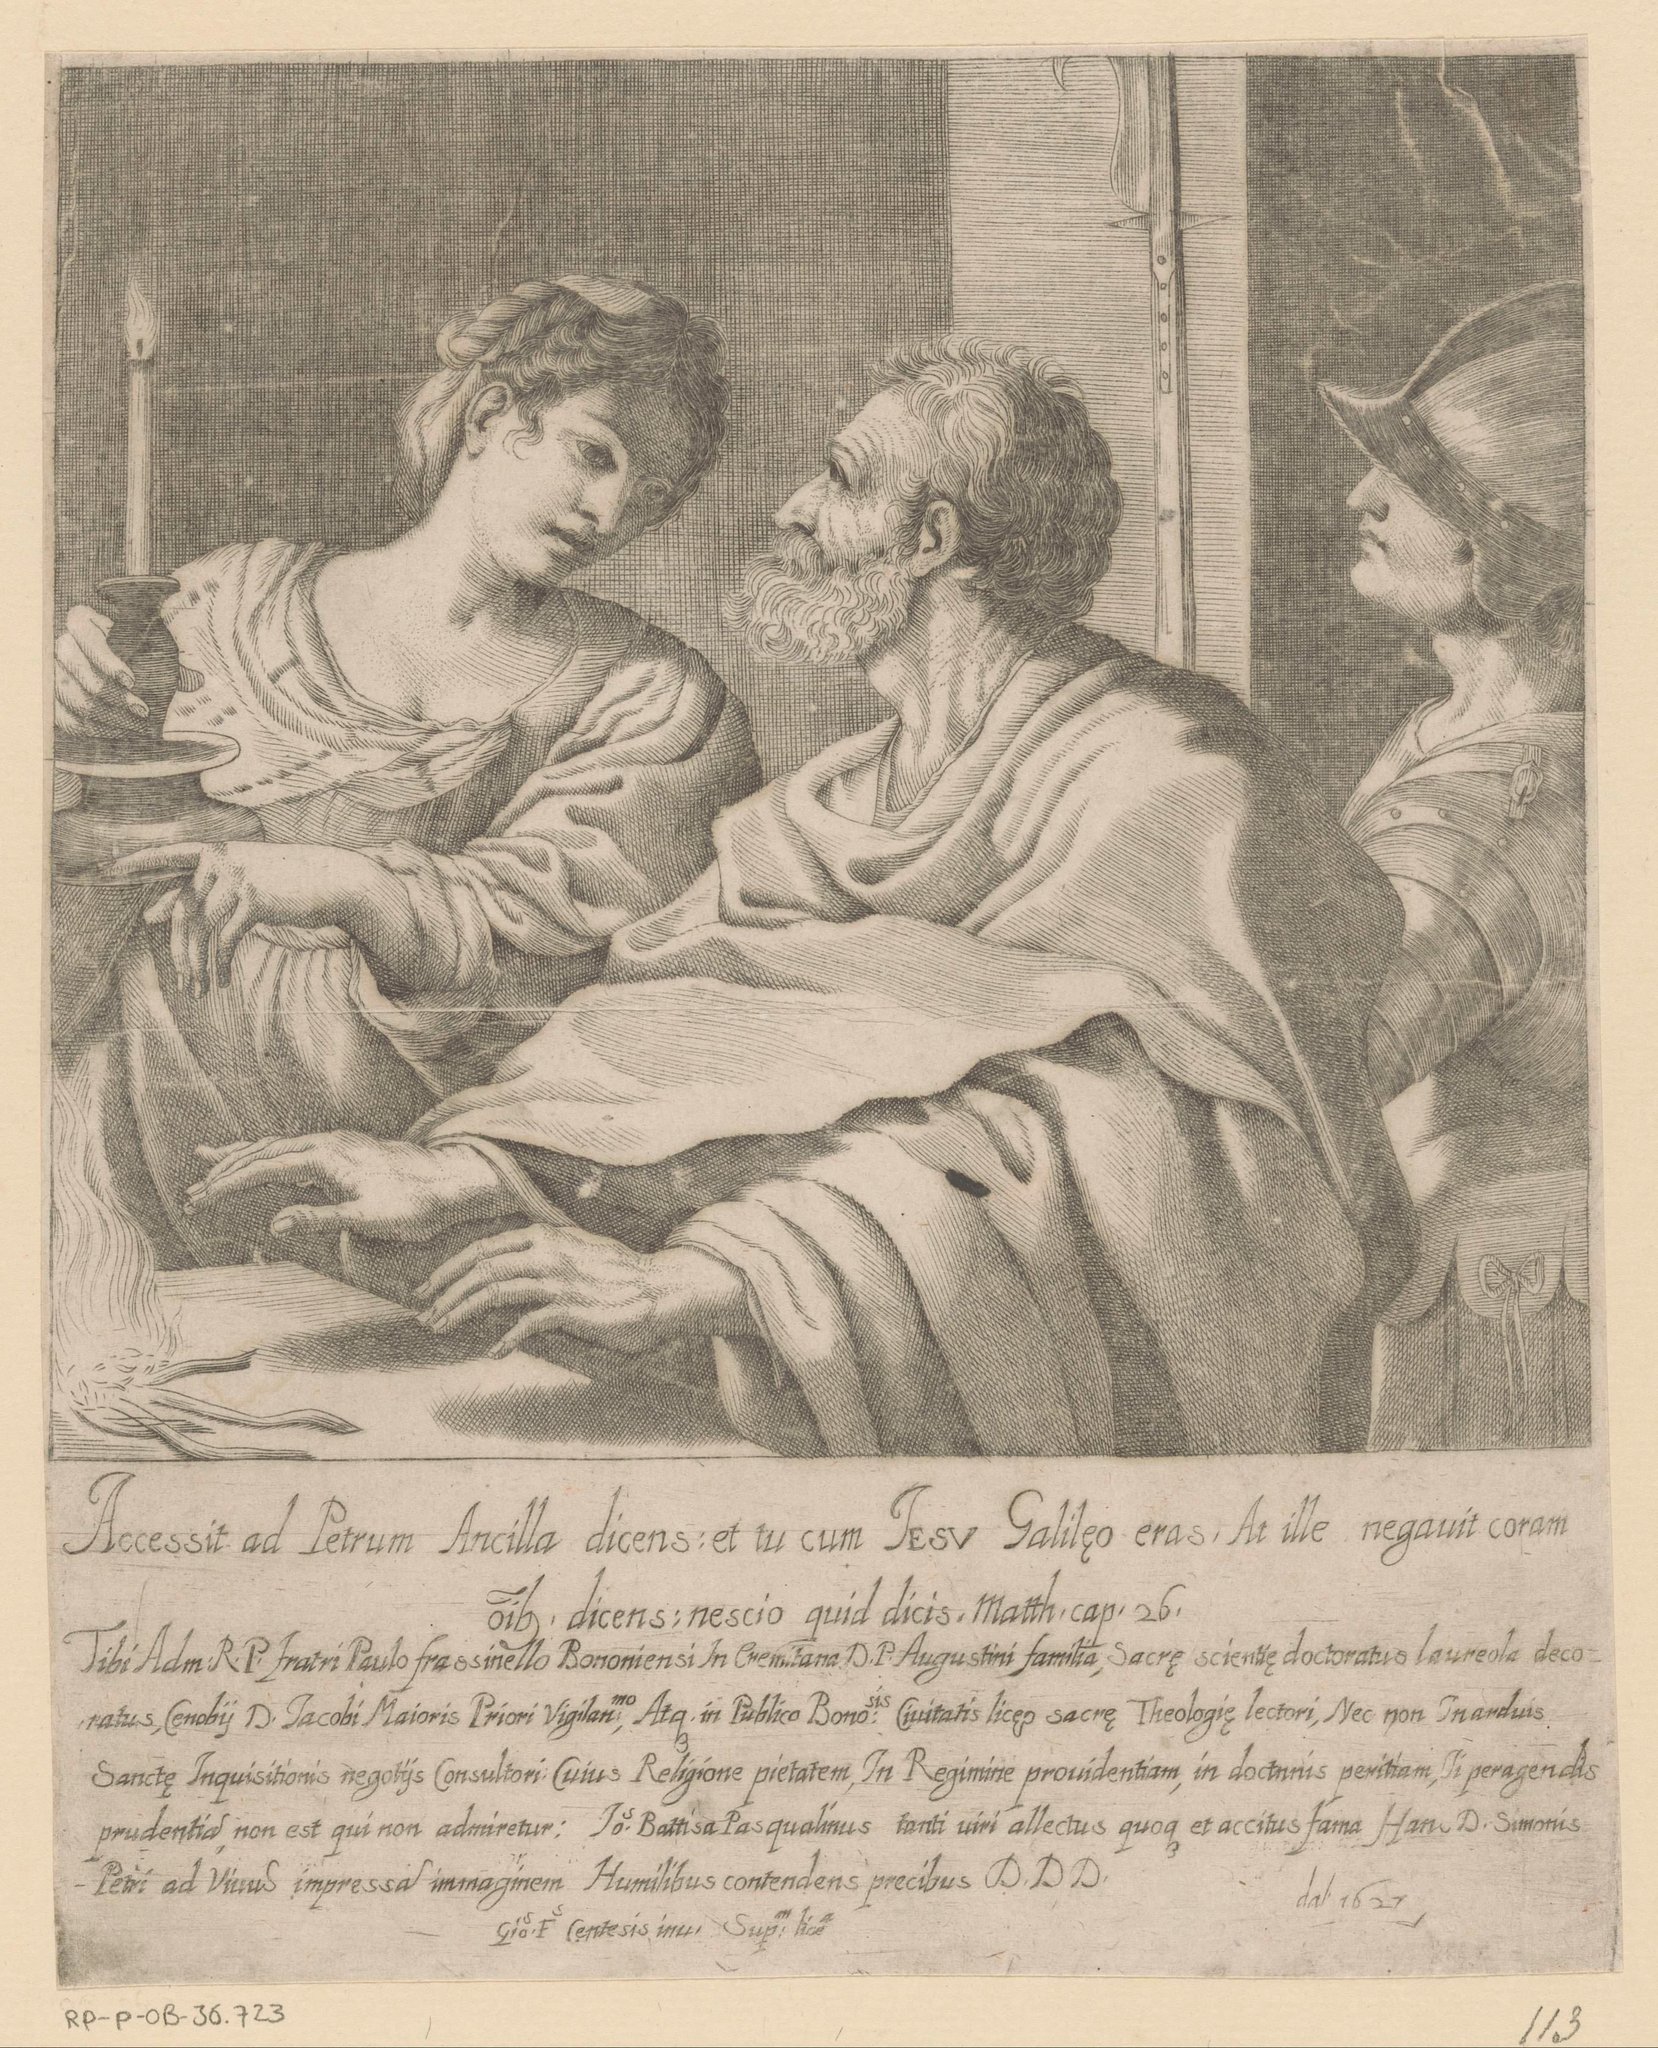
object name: print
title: Verloochening van Petrus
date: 1627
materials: paper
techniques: engraving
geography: italy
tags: peter denies christ, usually before a girl-servant and some soldiers, candle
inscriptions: collector's mark: Lugt 240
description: In aanwezigheid van een soldaat wordt Petrus herkend als volgeling van Christus door een dienares van Kajafas. Petrus ontkent dat te zijn, waarmee hij Christus verloochent. Nadat Petrus drie keer heeft ontkend, zal de haan kraaien. Latijnse tekst met Bijbelcitaat uit Mattheüs 26 en opdracht in de ondermarge.